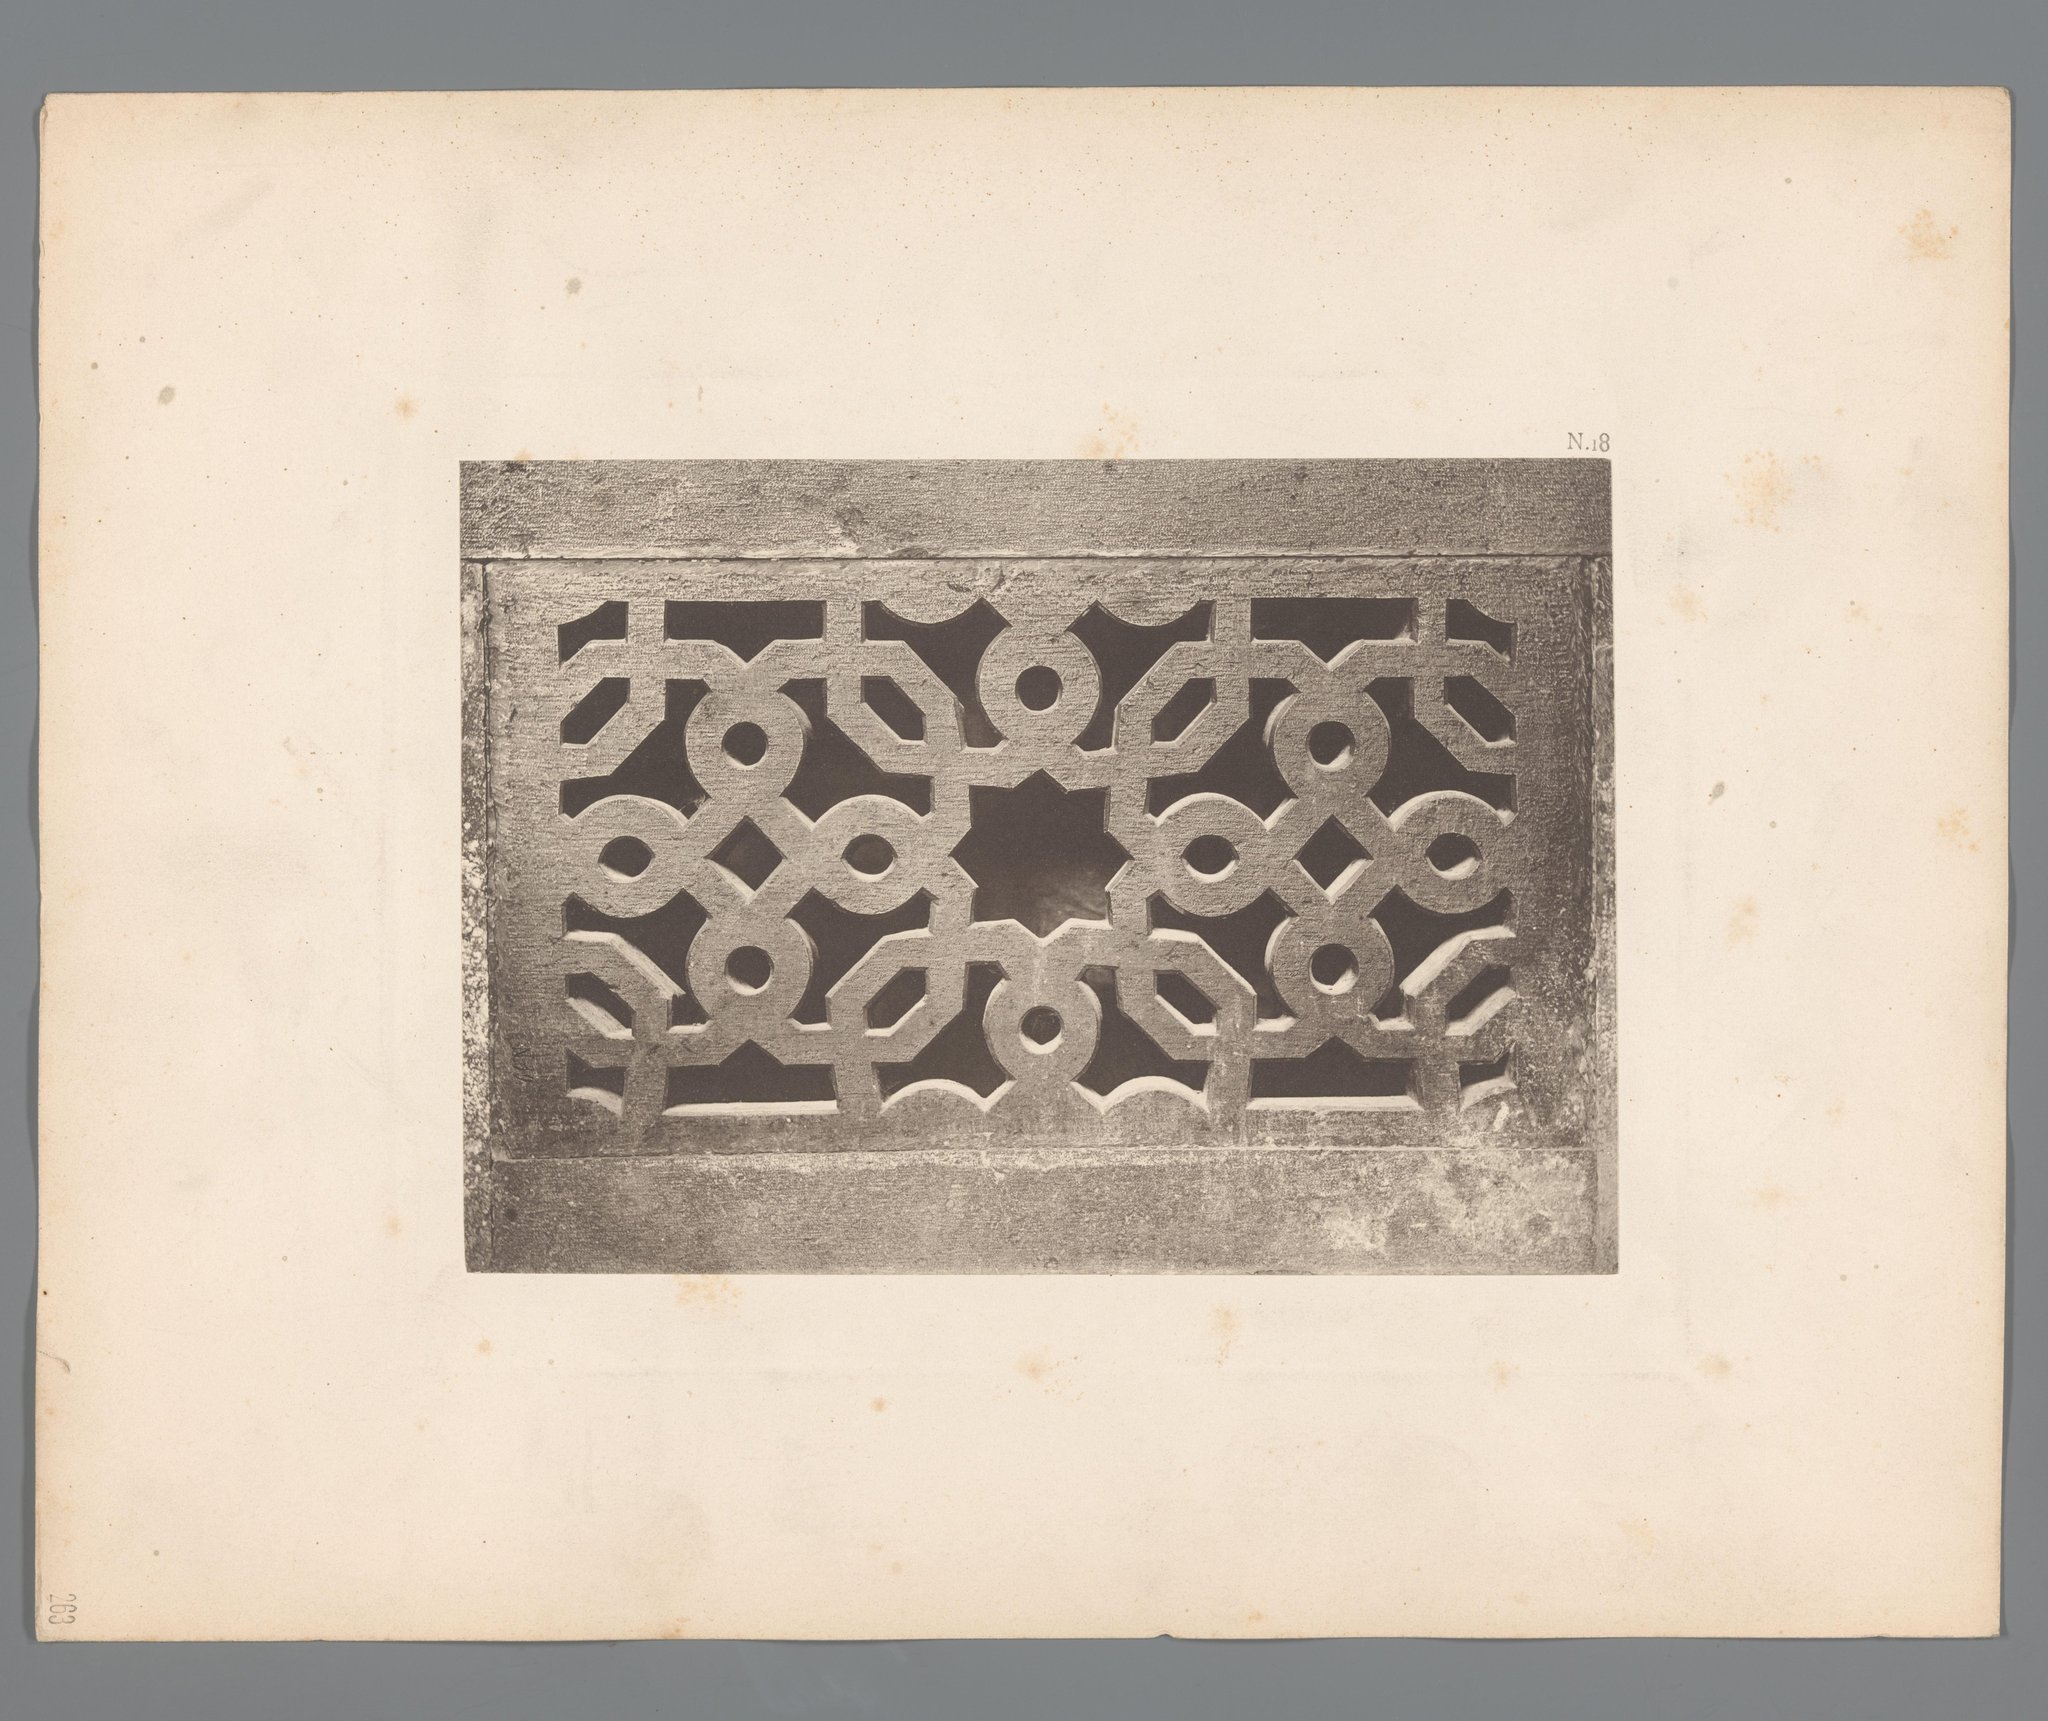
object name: photomechanical print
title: Detail van de San Marco in Venetië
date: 1880-1885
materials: paper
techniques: photograph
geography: venice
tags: piece of sculpture, reproduction of a piece of sculpture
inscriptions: number: ‘N.19.’, number: ‘263’, number: ‘N.18’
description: Deze prent maakt deel uit van een omslag met 58 prenten op 50 bladen.